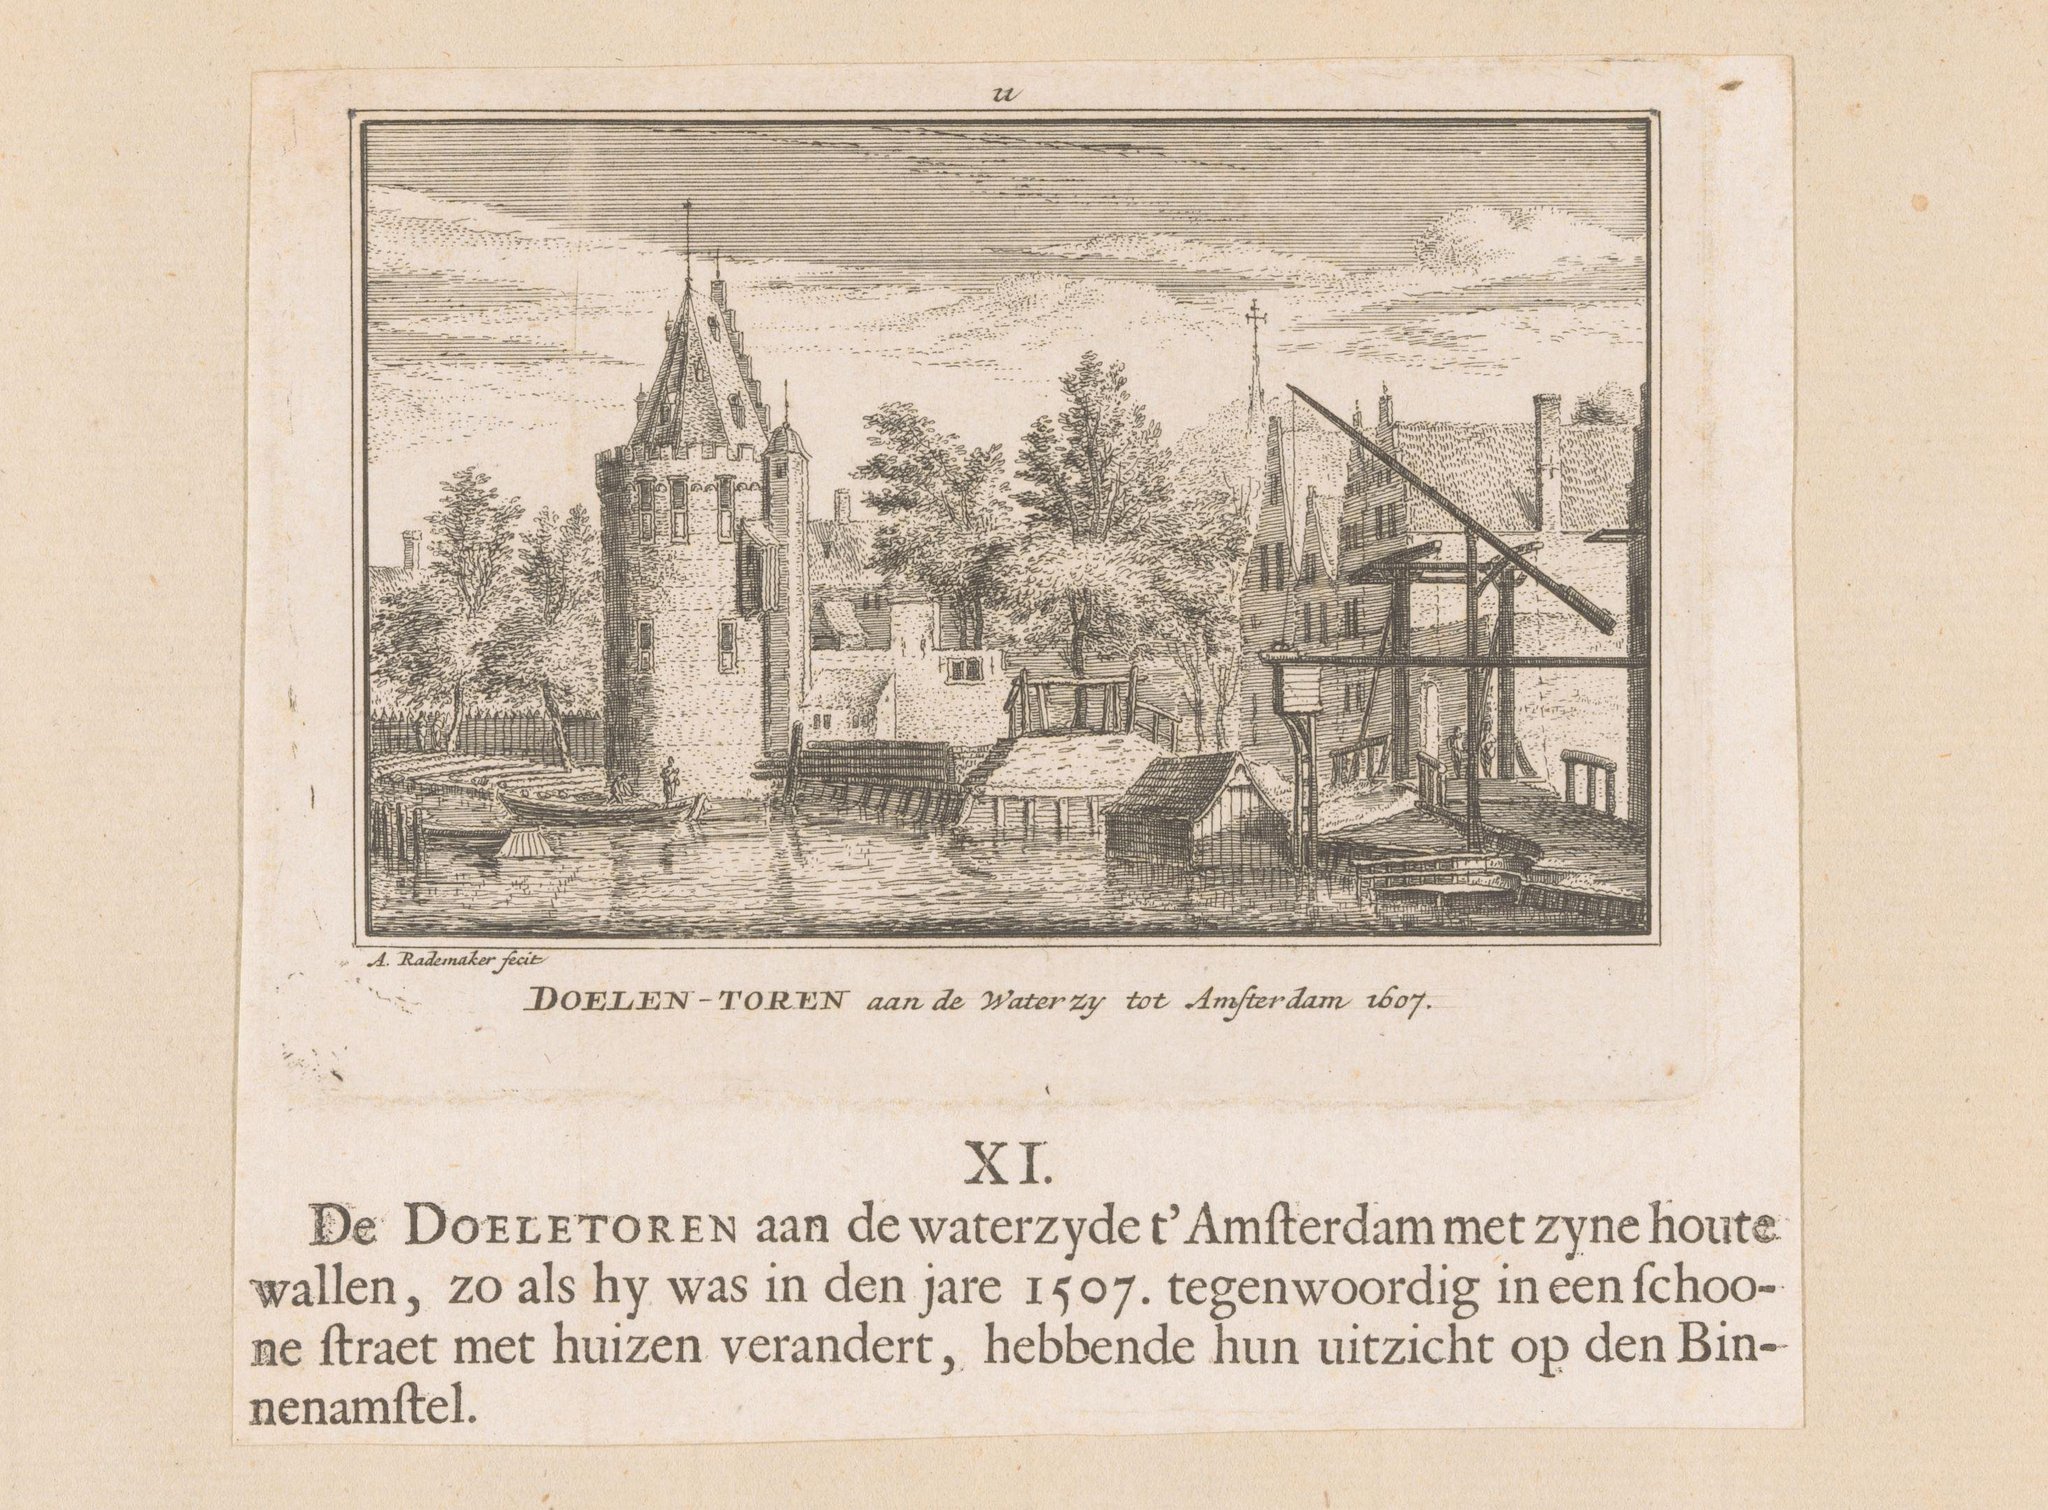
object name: book illustration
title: Doelen-toren aan de waterzy tot Amsterdam 1607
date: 1725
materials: paper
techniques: etching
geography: amsterdam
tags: canals, waters (in city), tower (of house or building)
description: Prent gebruikt in: Rademaker, Abraham. Kabinet van Nederlandsche outheden en gezichten: vervat in 300 konstplaaten (…). 2 dln. Amsterdam: Willem Barents, 1725, plaat 11. Na 1725 is deze prent nog in verschillende heruitgaven verschenen, in 1727-1733, 1770-1771 en 1792-1803. Uit welke uitgave het huidige exemplaar precies komt is niet na te gaan.